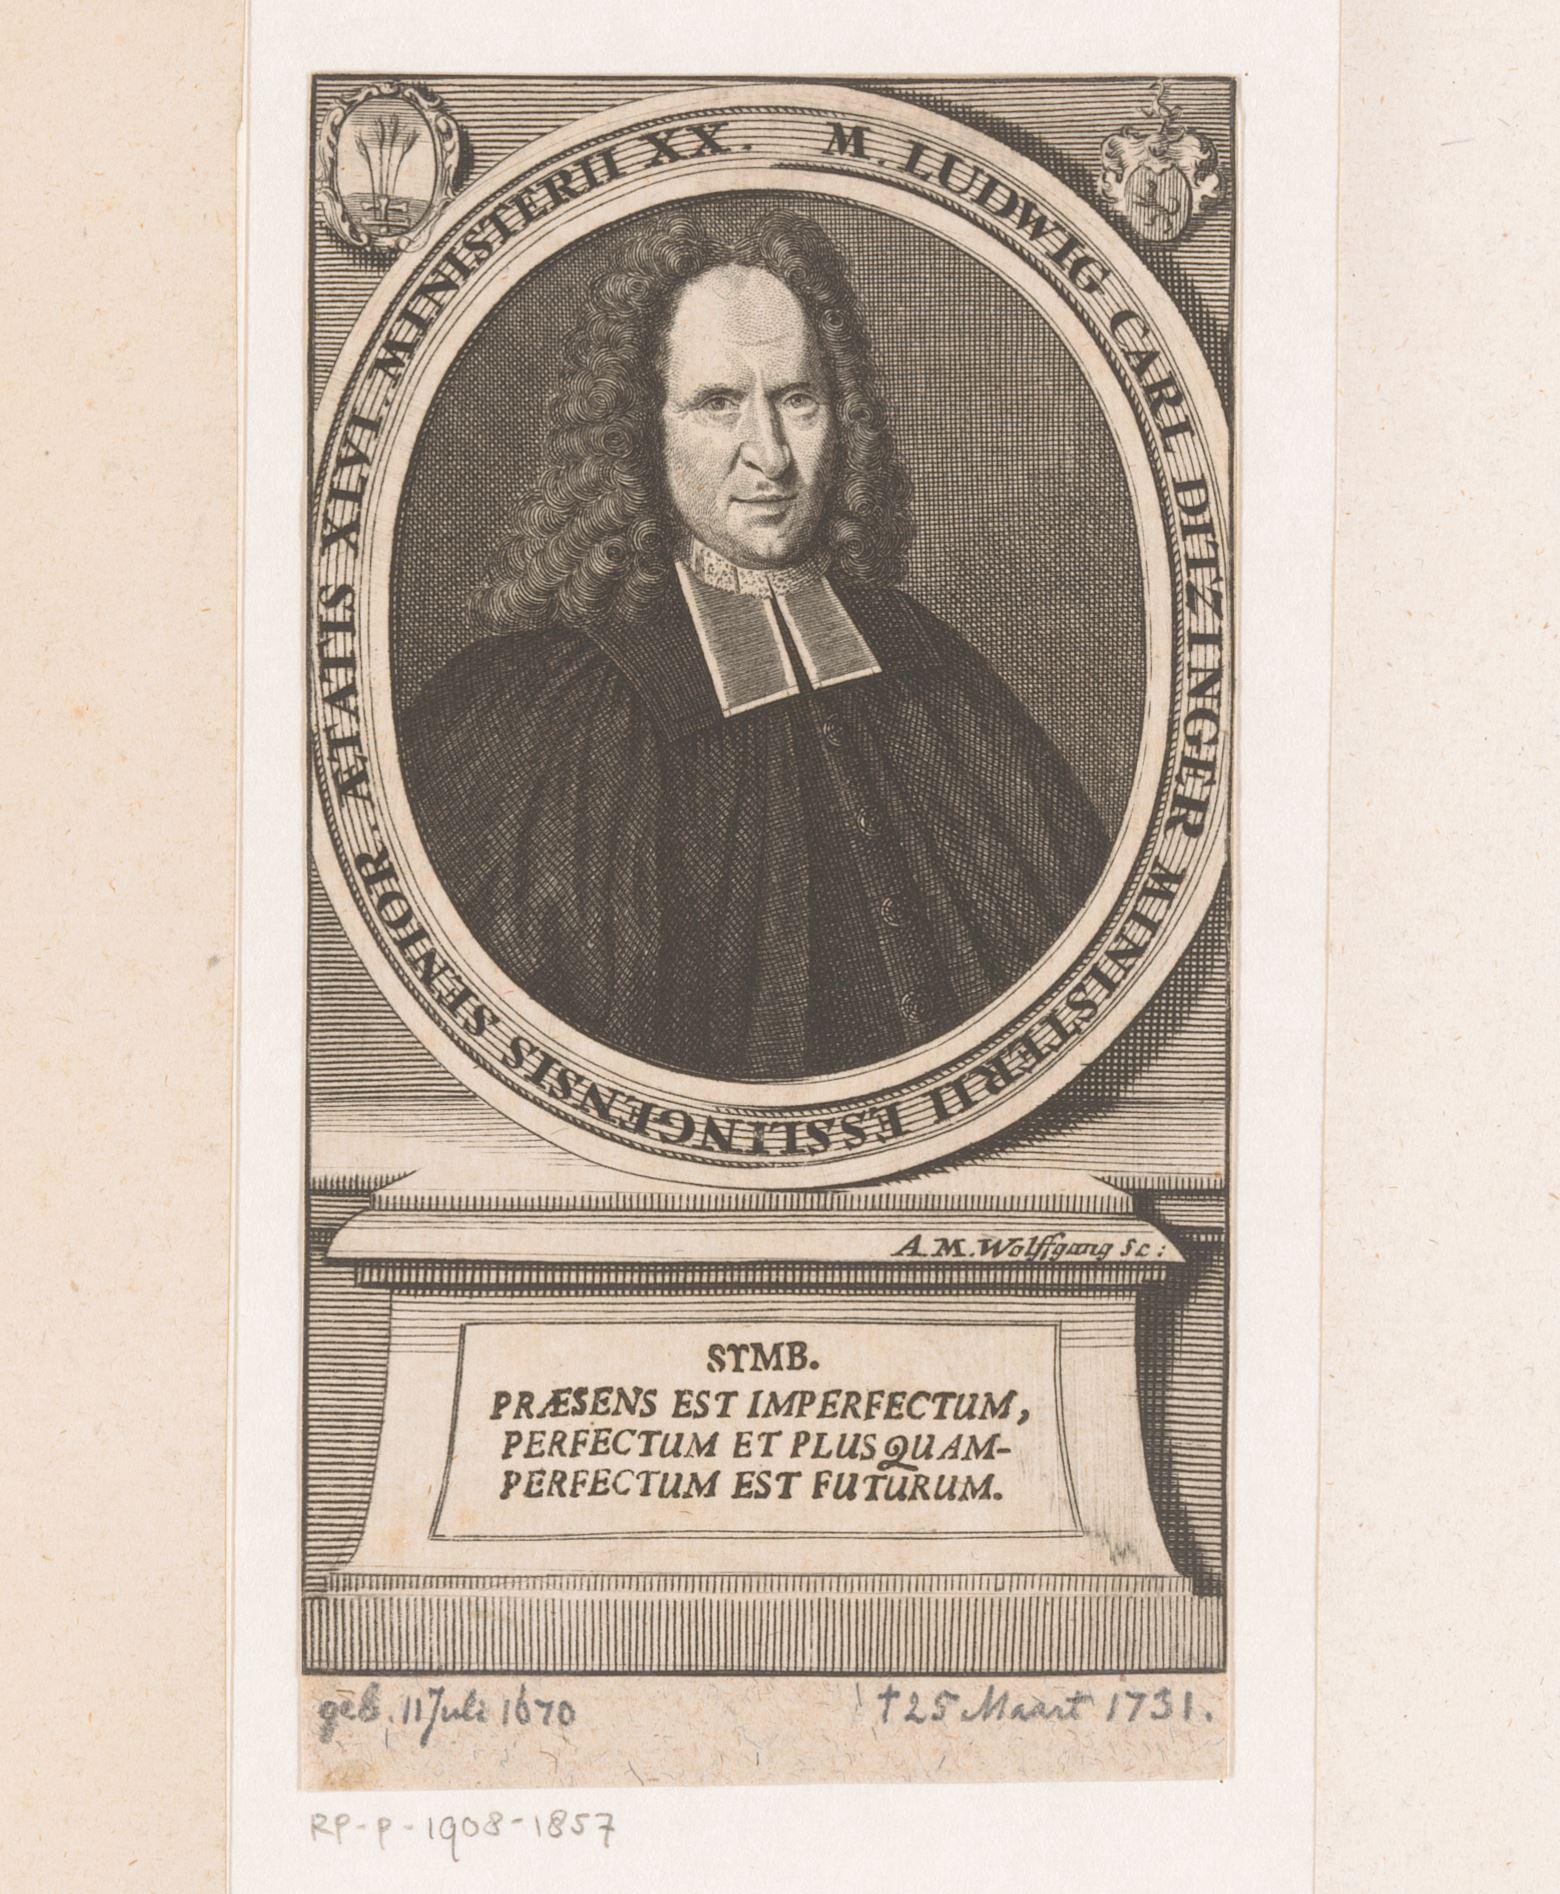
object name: print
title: Portret van Ludwig Carl Ditzinger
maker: andreas matthäus wolfgang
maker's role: print maker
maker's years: 1660-1737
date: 1700-1737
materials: paper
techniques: engraving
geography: germany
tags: historical persons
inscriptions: collector's mark: Lugt 2228, collector's mark: Lugt 9